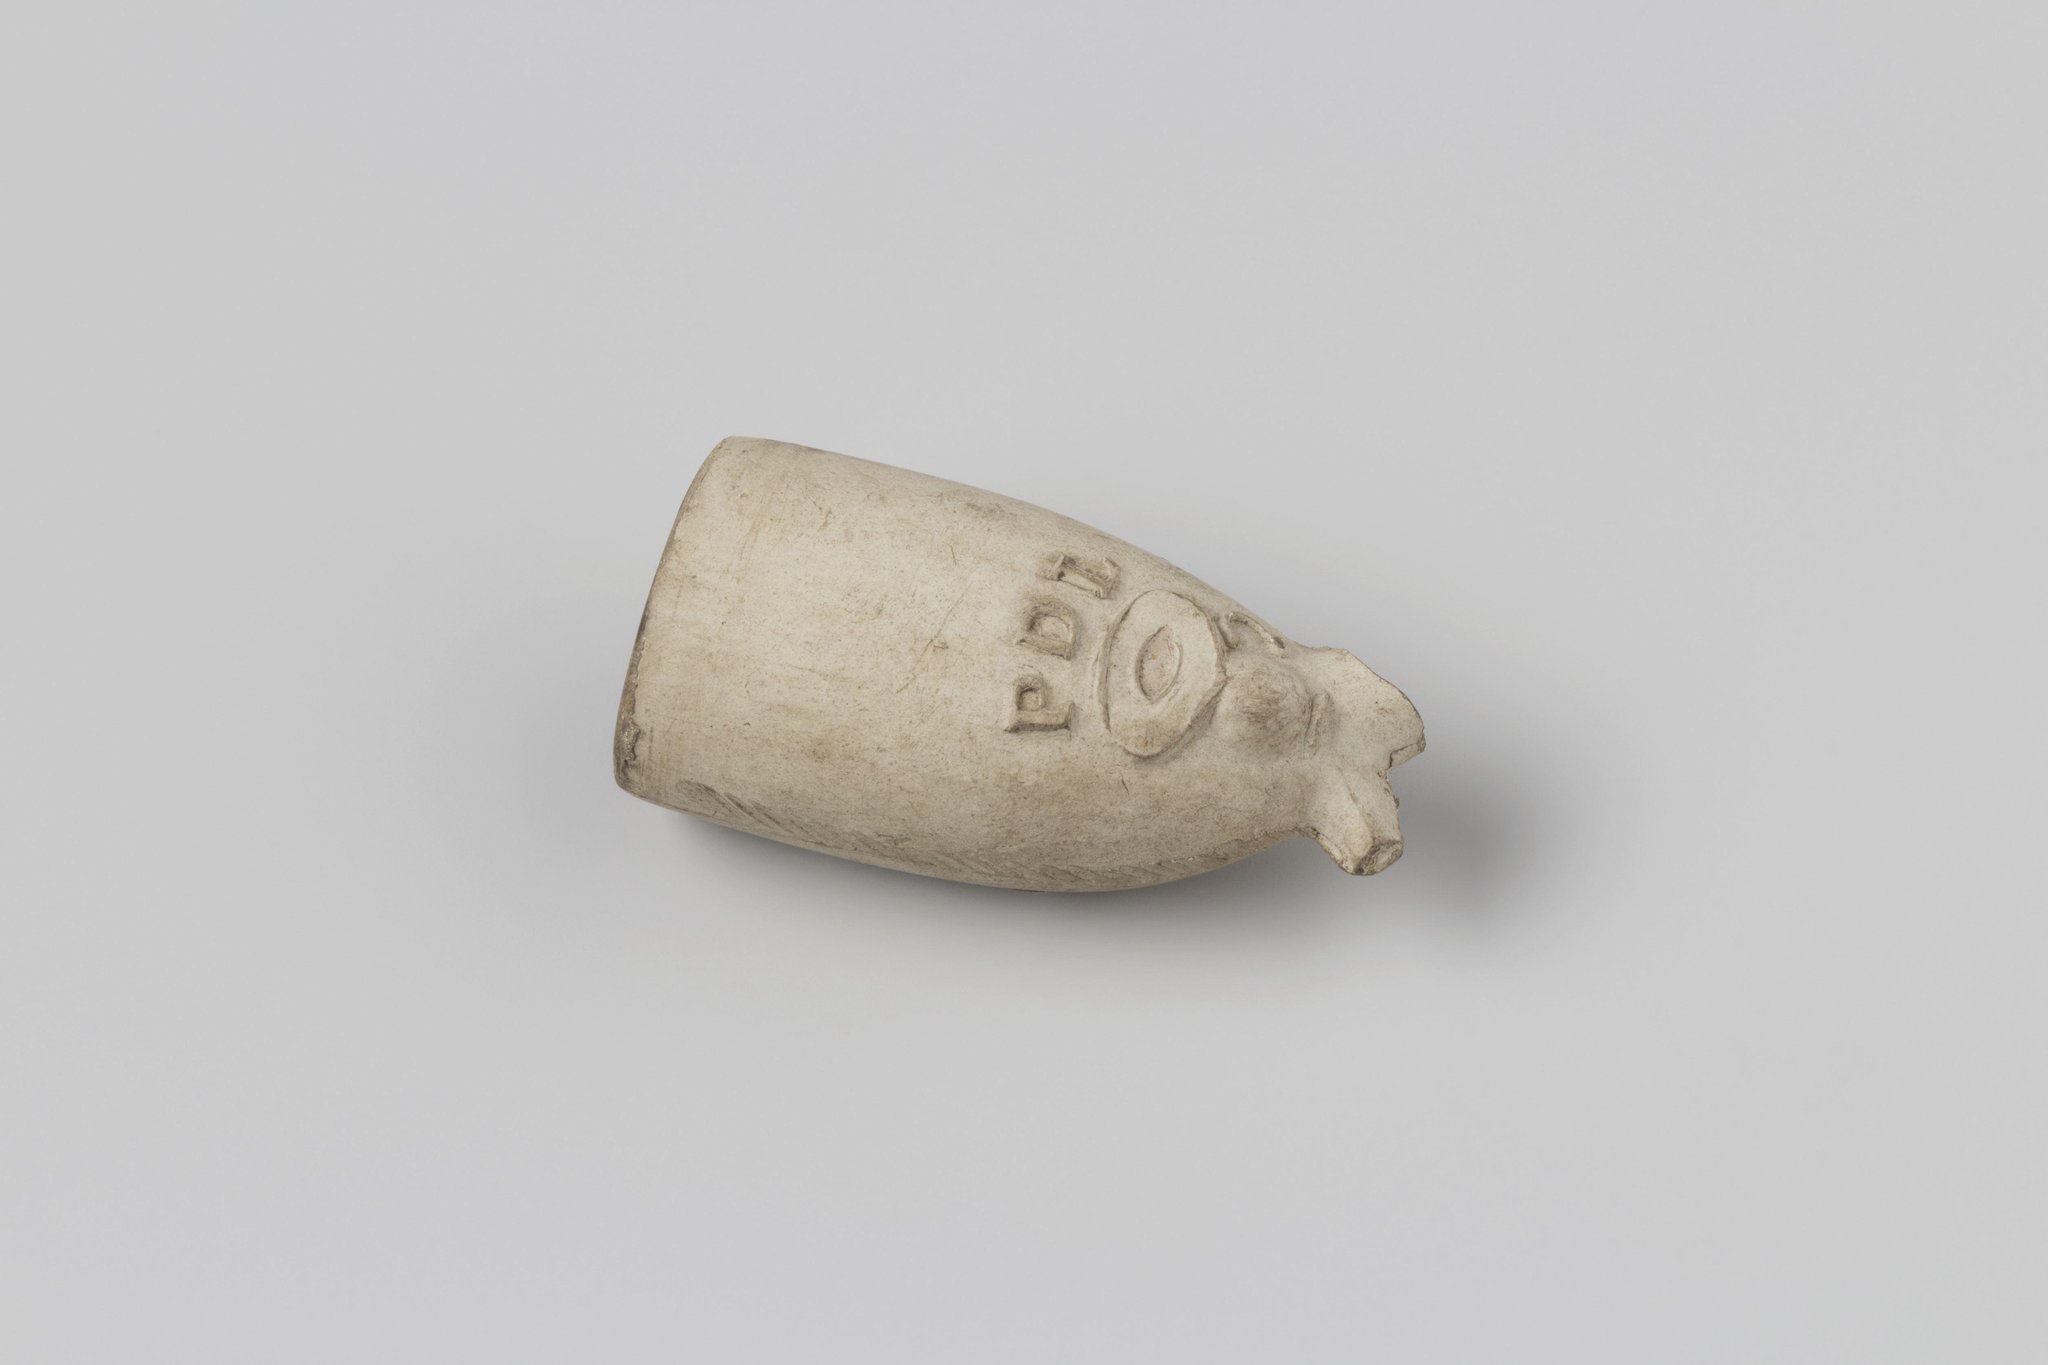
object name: pipe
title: Fragment pijpenkop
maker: pieter de leeuw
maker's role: pijpenfabrikant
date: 1745-1785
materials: clay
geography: schoonhoven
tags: the hague, rotterdam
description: Fragment pijpenkop met de letters P D L en een kwispedoor. Van de opgravingen op de Hofstede Arentsburg 1827-1831 onder toezicht van Professor Reuvens.